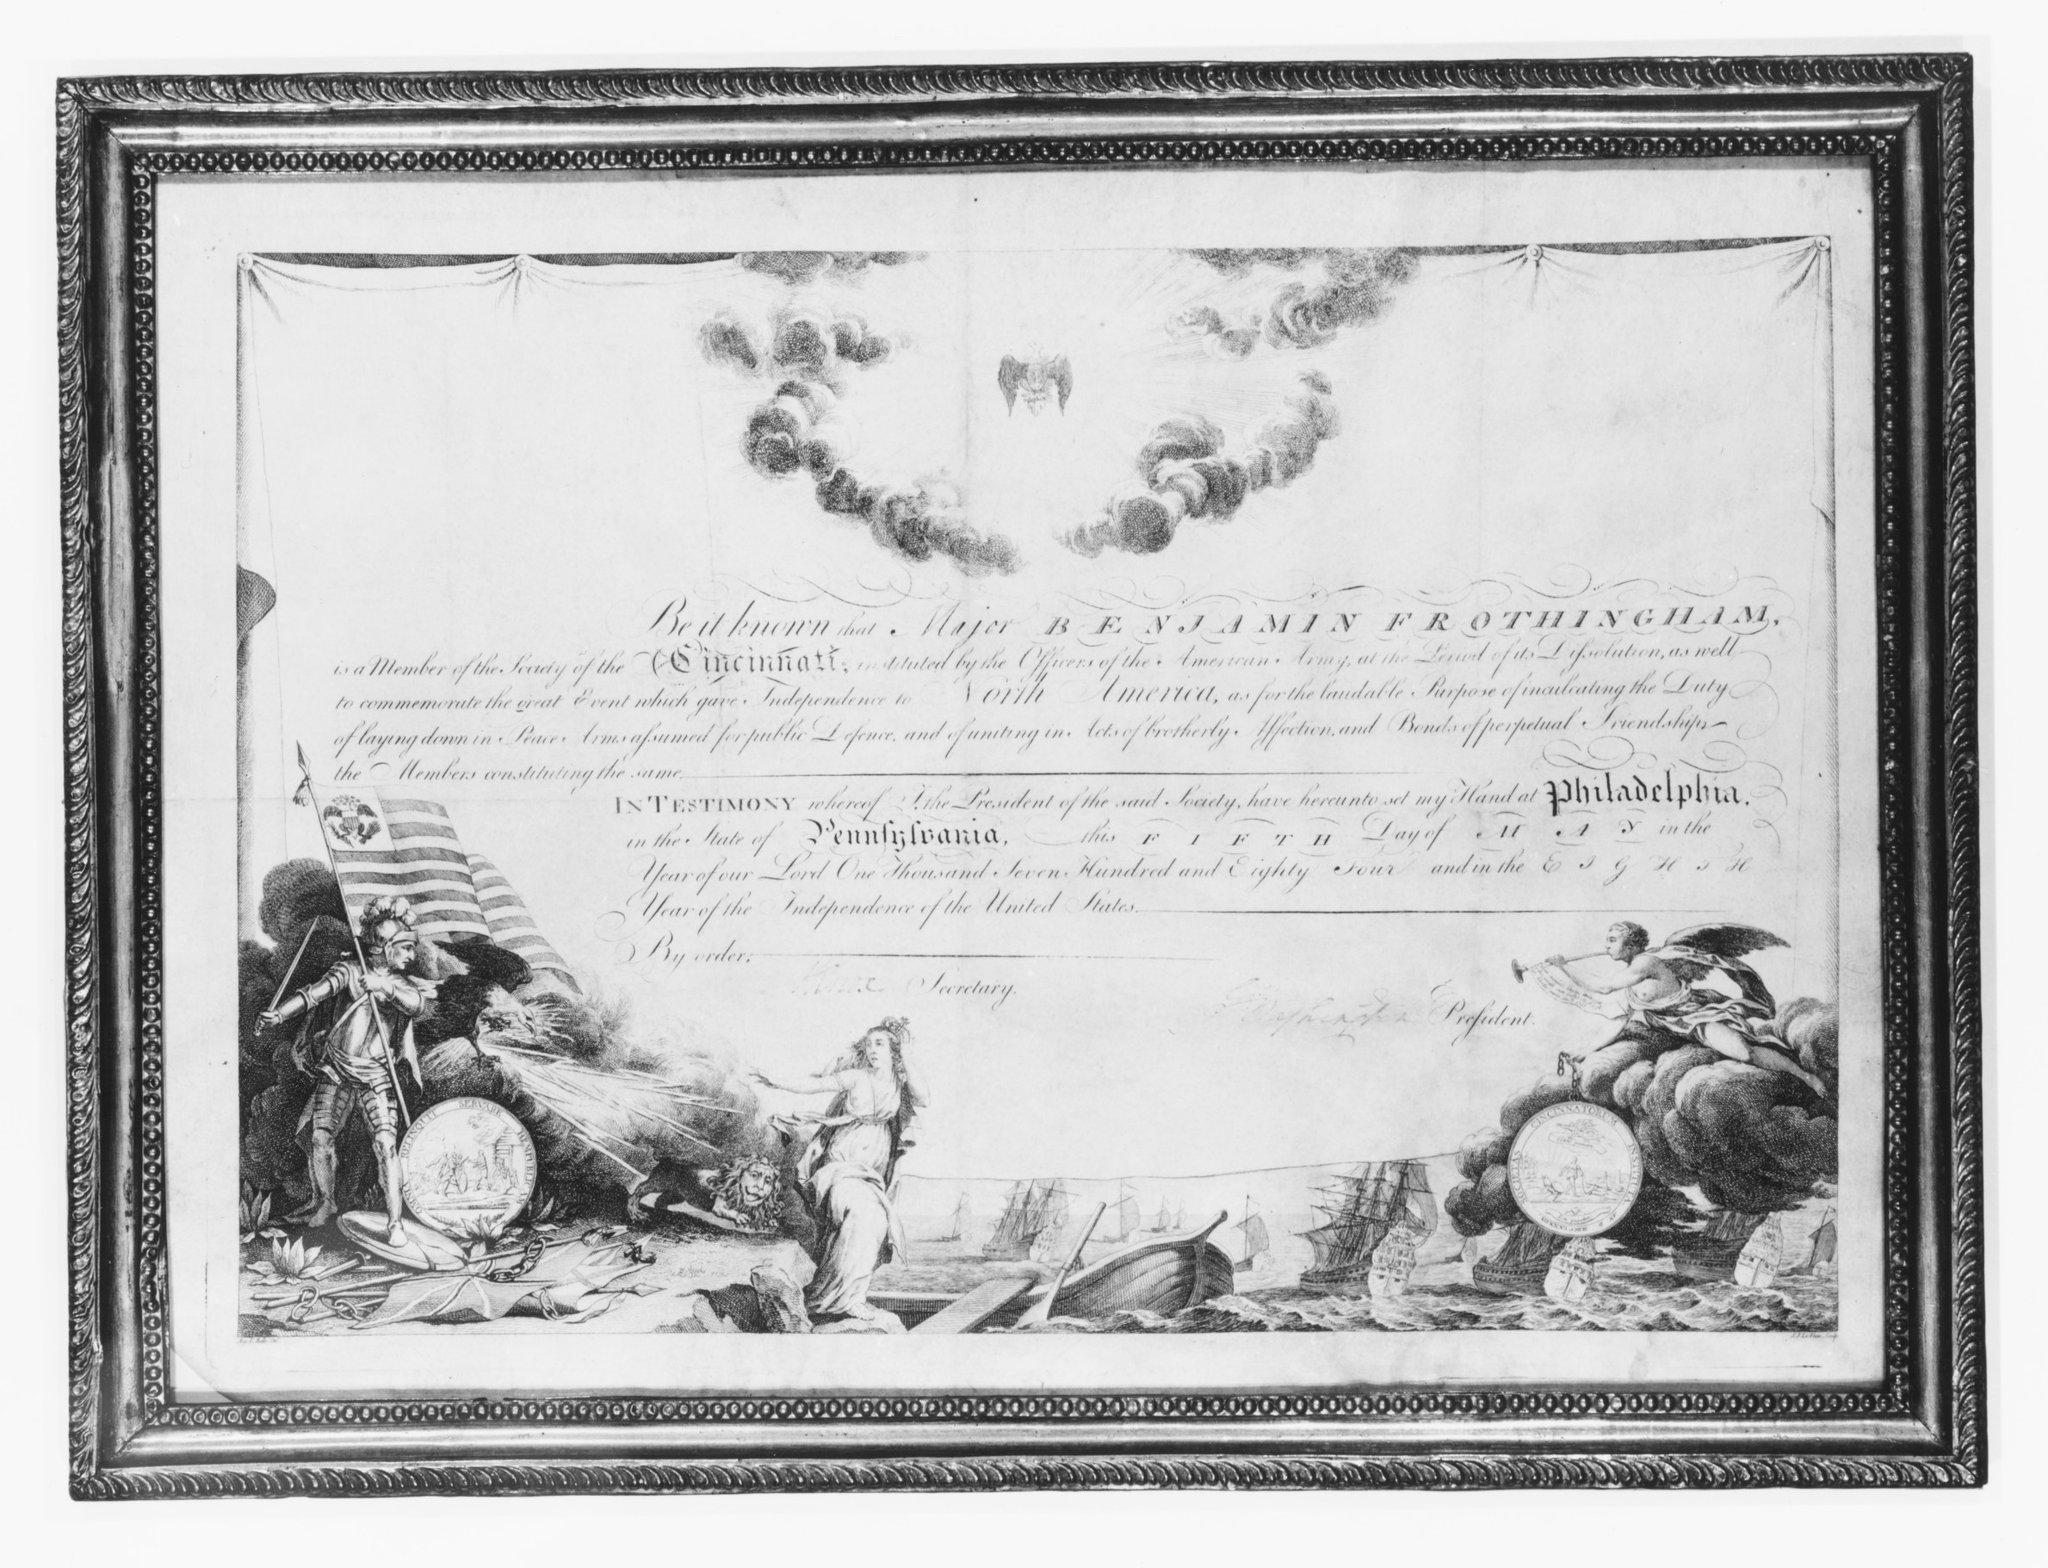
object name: membership certificate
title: Membership Certificate of the Society of the Cincinnati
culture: american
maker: aug. l. belle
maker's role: designer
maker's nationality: american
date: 1783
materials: parchment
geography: united states